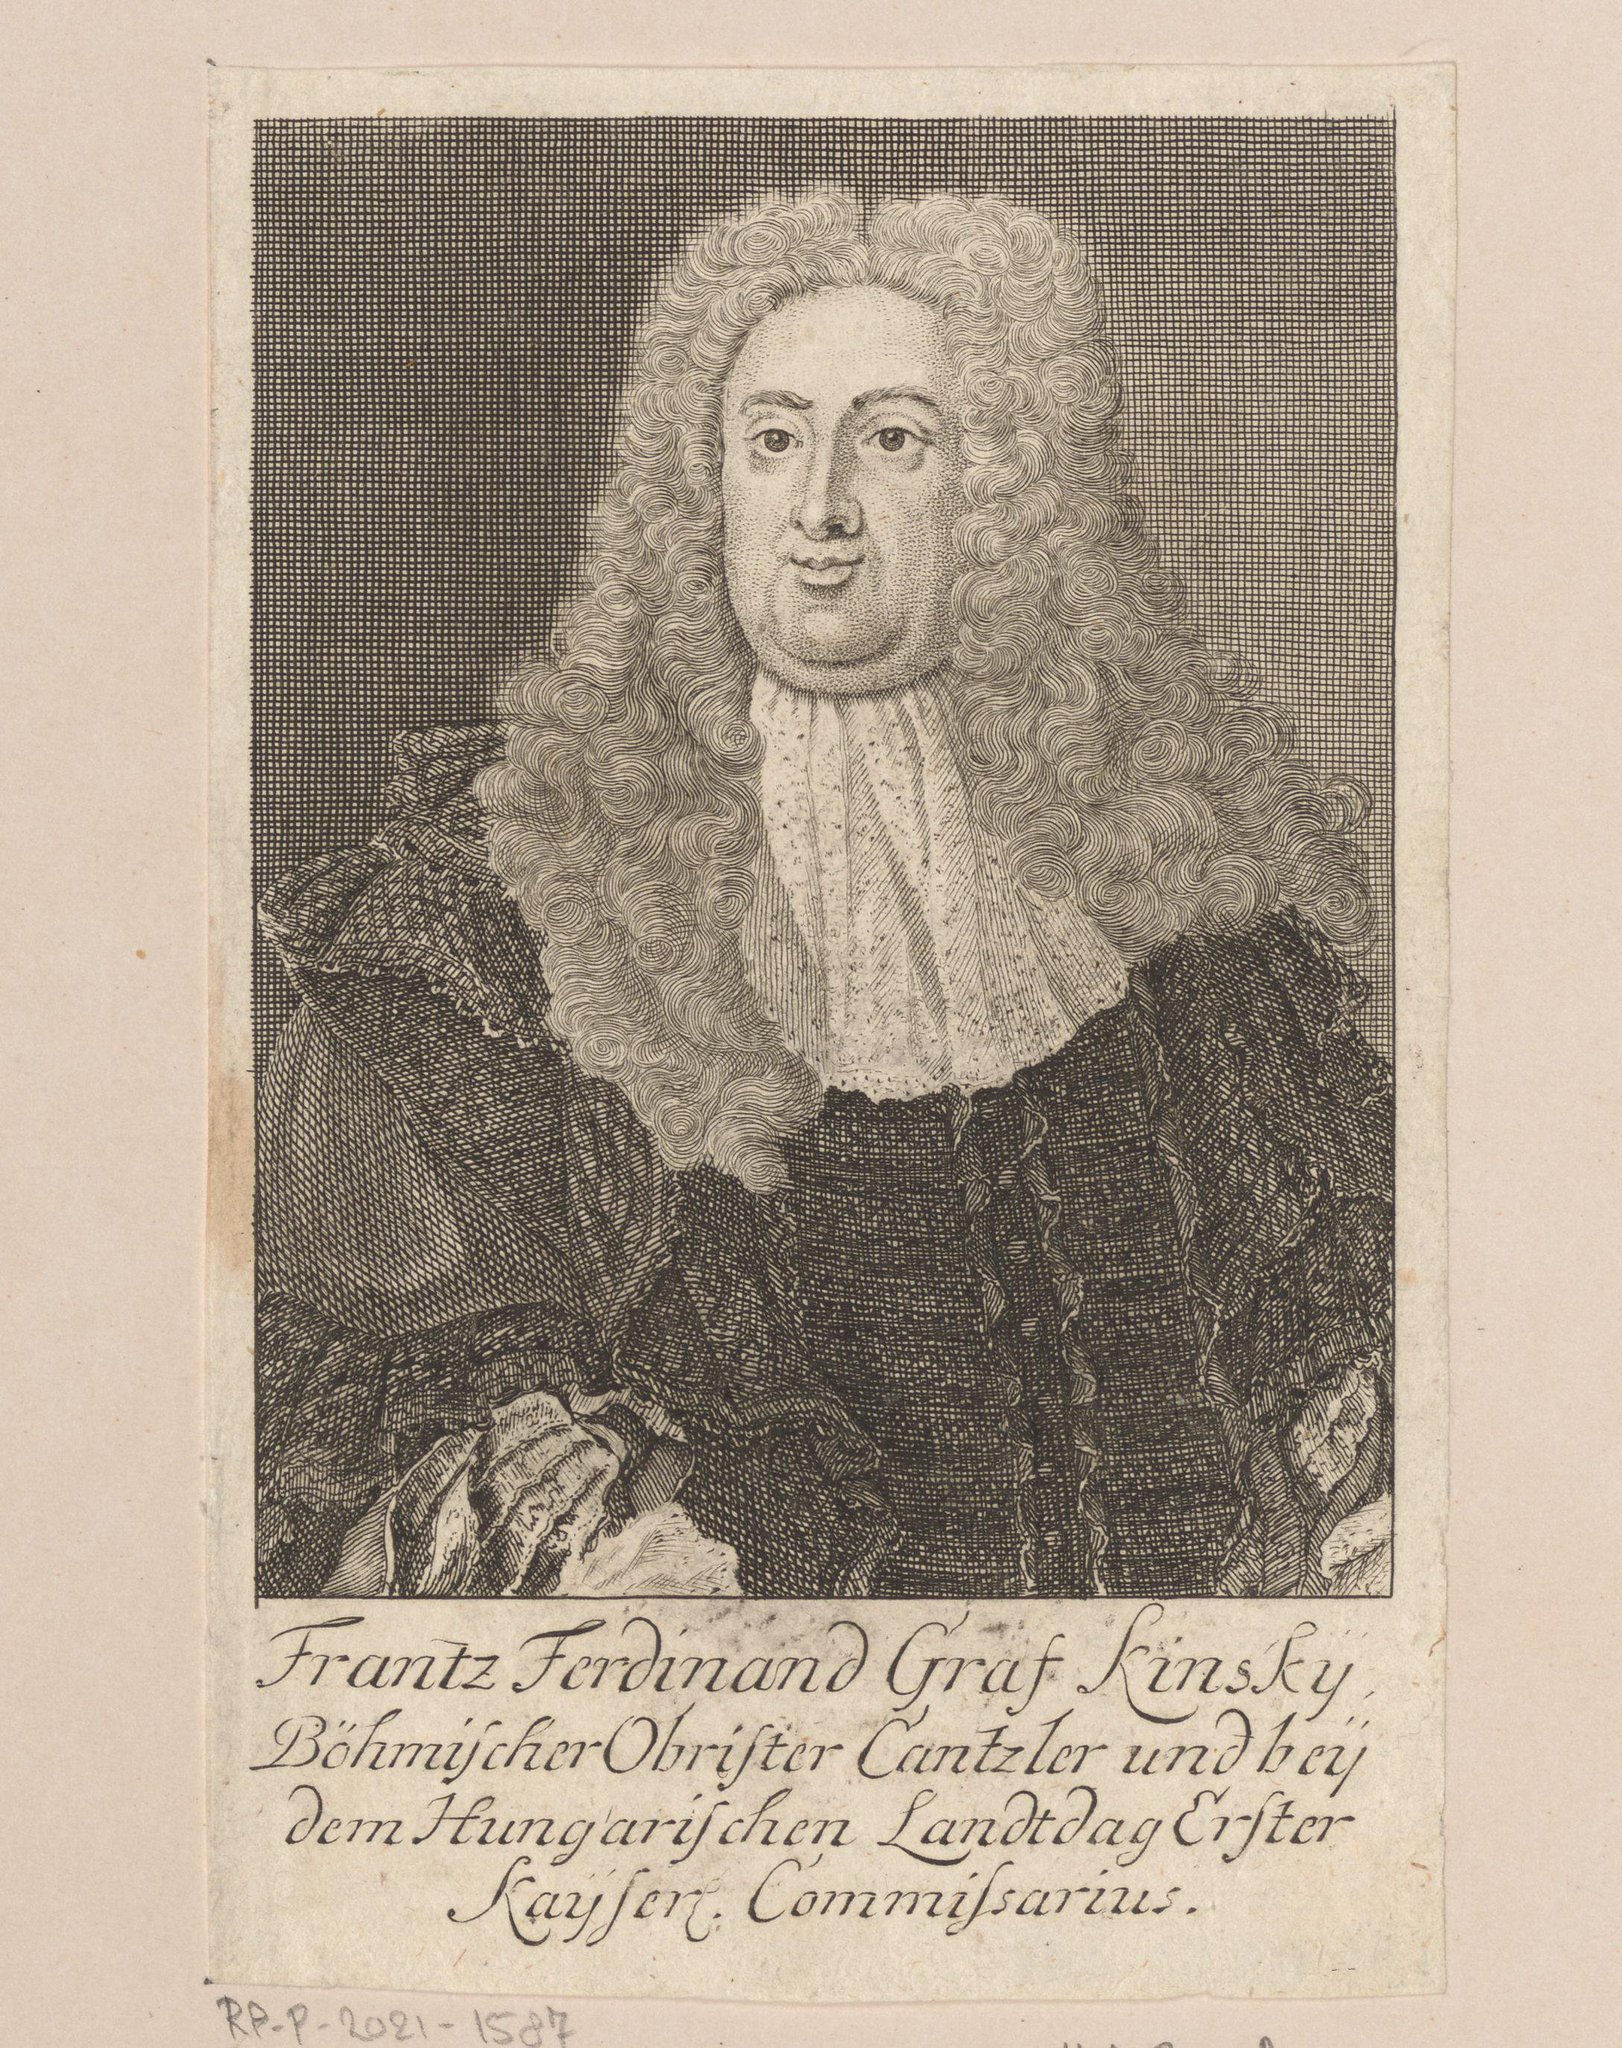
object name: print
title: Portret van Franz Ferdinand graaf Kinsky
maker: martin bernigeroth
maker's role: print maker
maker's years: 1670-1733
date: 1730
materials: paper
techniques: engraving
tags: historical persons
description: Prent mogelijk uit: Die Europäische Fama (...). Leipzig: Johann Friedrich Gleditsch, 1730, dl. 327.